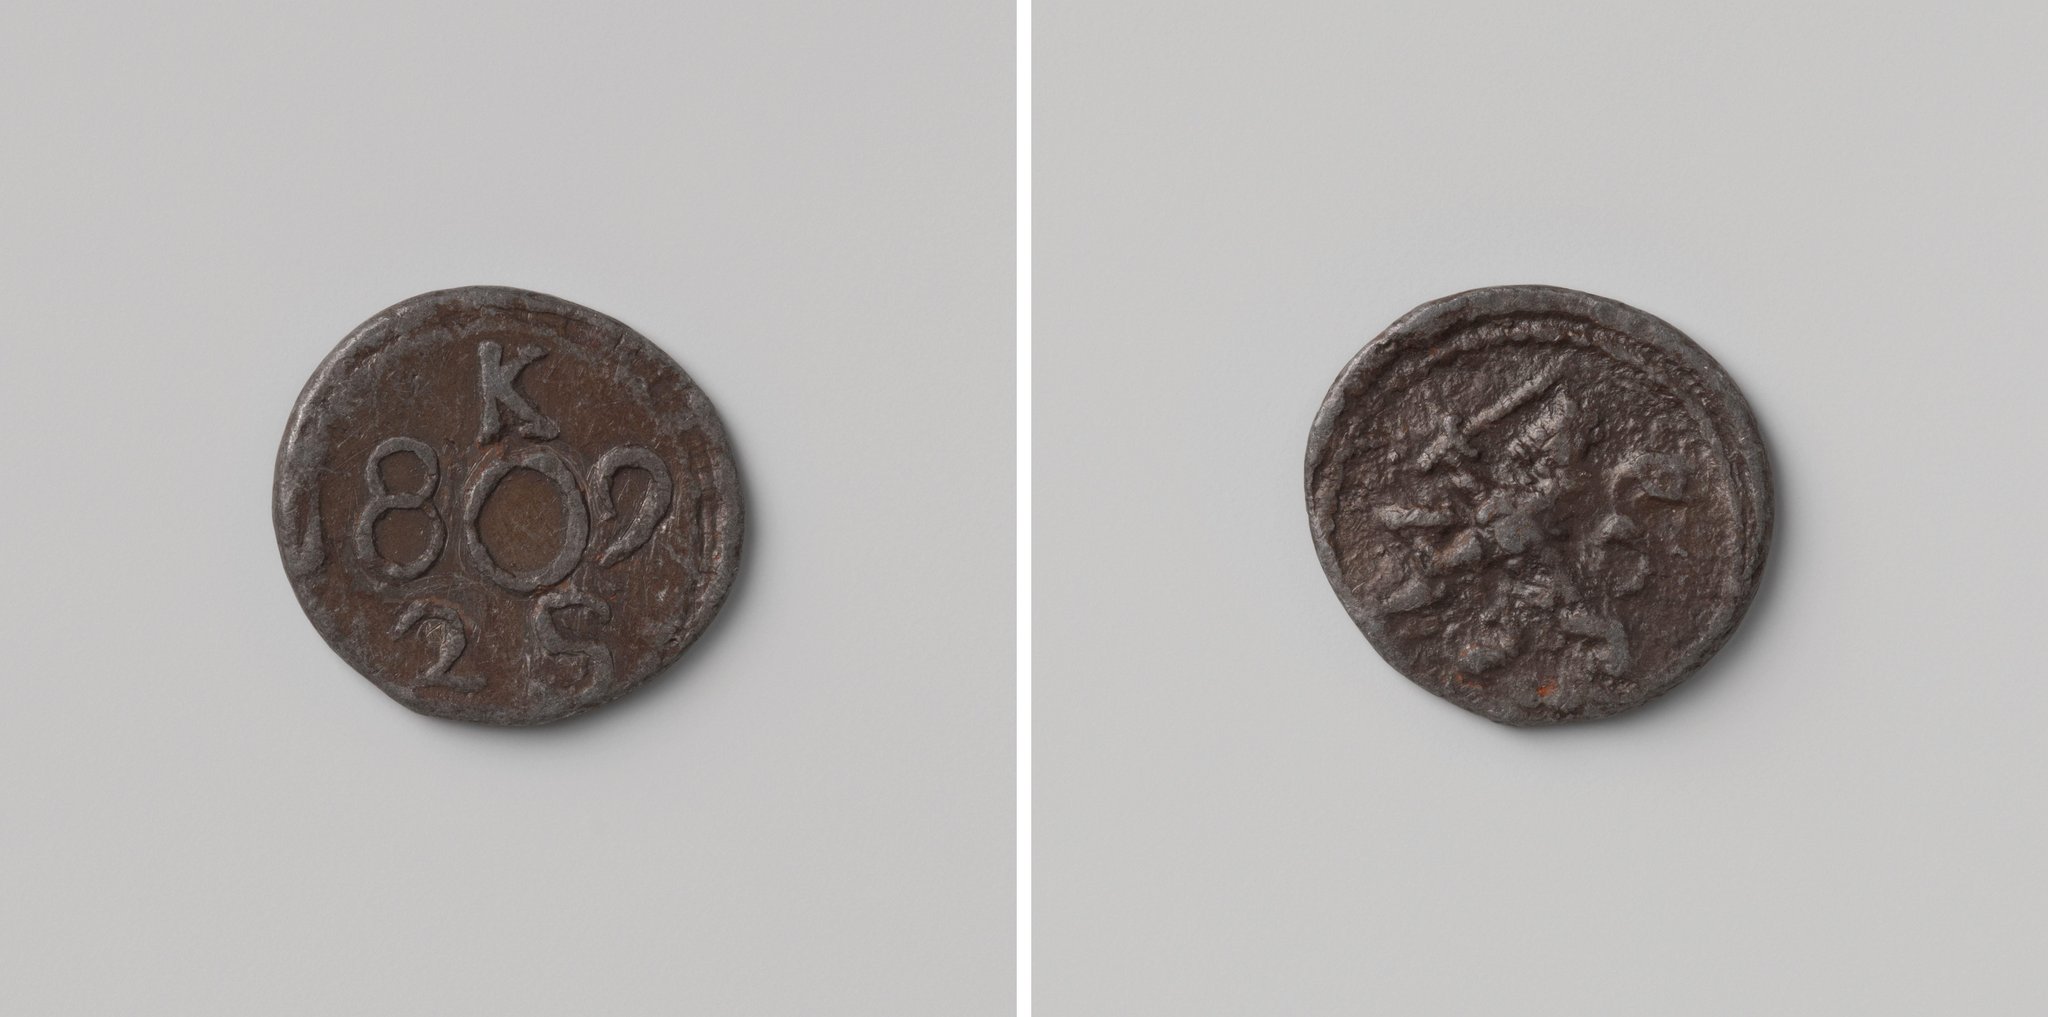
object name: tax token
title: Loden penning van de Kille (Dordtse Kil) met K 1802 2 S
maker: Anonymous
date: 1802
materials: lead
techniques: striking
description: Voorzijde: opschrift K 1802 2s. Keerzijde: gekroonde leeuw met zwaard en pijlenbundel